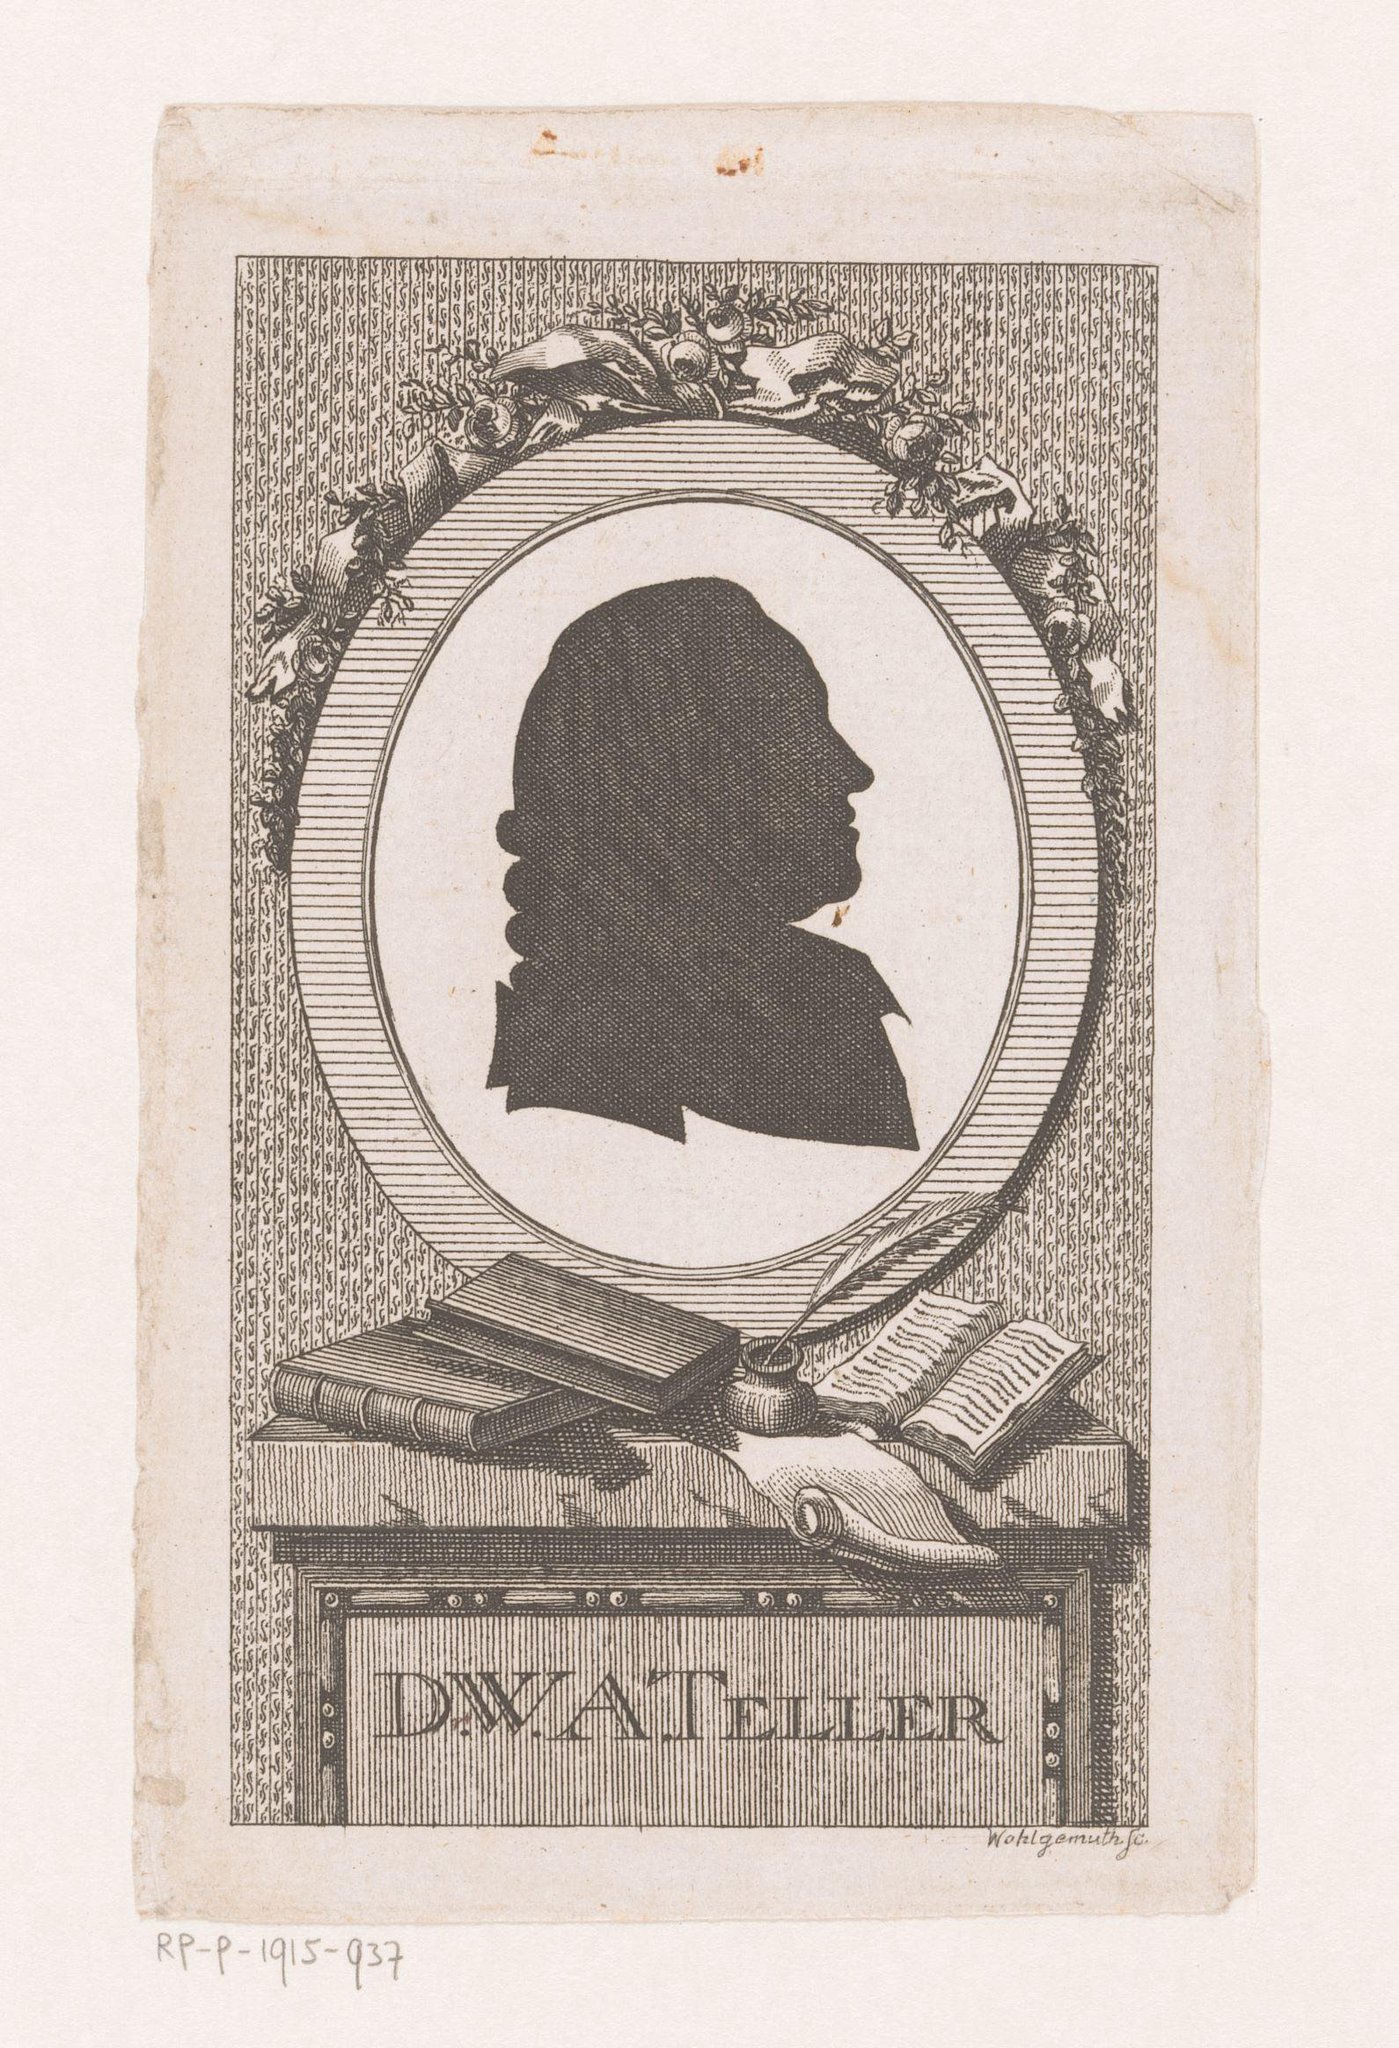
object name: print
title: Silhouetportret van Wilhelm Abraham Teller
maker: wohlgemut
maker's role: print maker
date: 1755-1799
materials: paper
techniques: etching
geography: germany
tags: berlin, historical persons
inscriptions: collector's mark: Lugt 2228